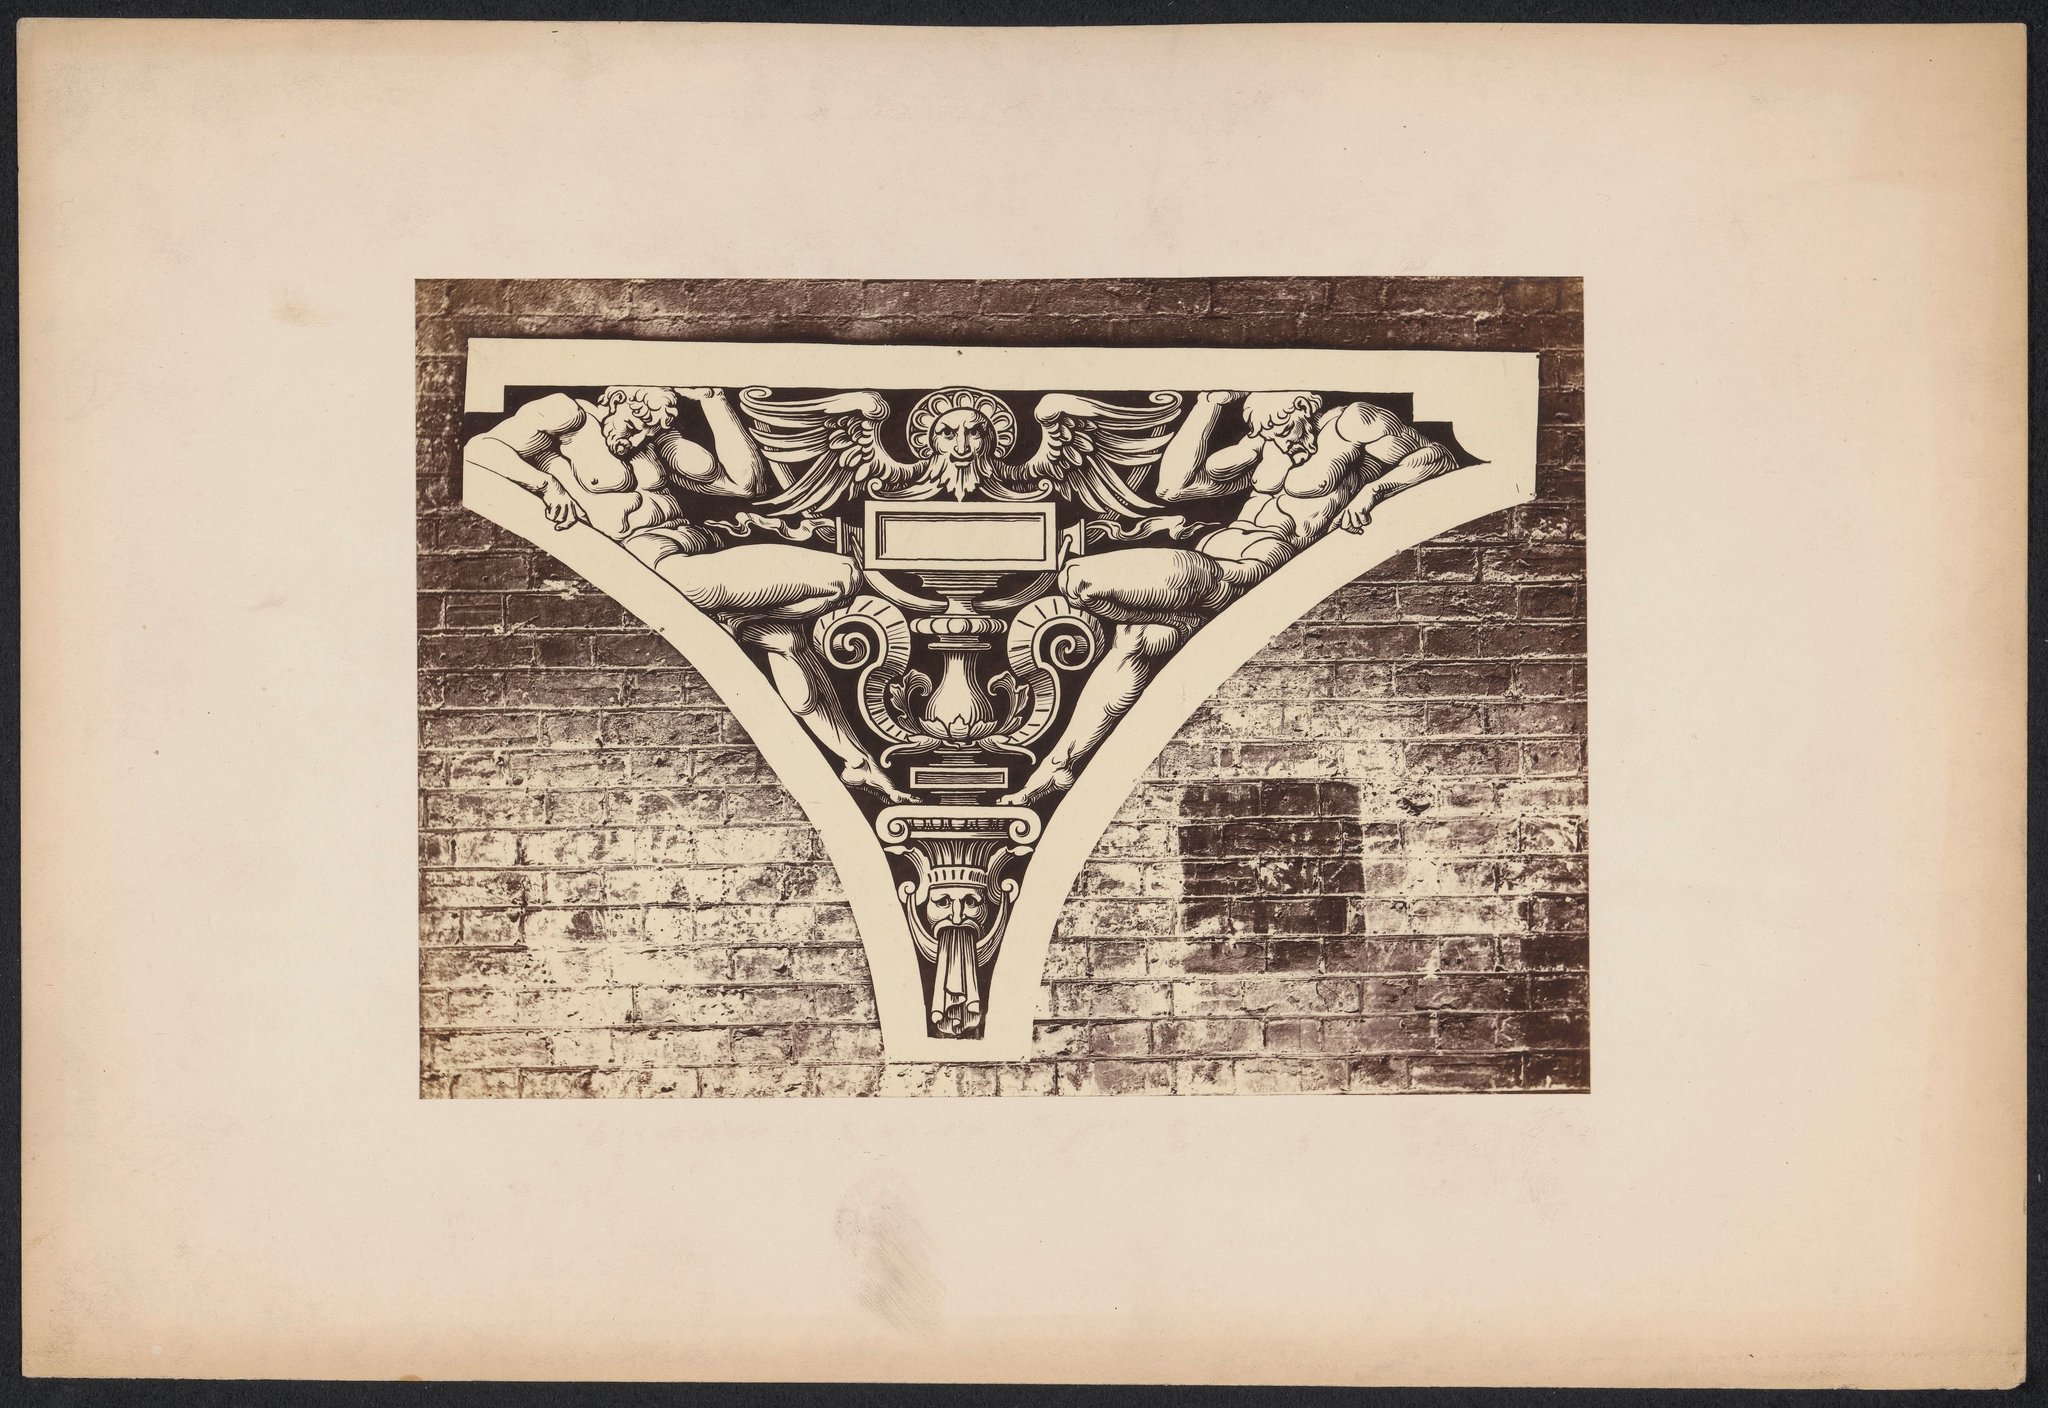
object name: photograph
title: Ornamentprent met twee leunende figuren op een muur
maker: Anonymous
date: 1875-1900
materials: cardboard, photographic support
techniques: albumen print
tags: other fantasy ornament, vase ~ ornament, leaning figure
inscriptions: collector's mark: Lugt 3937